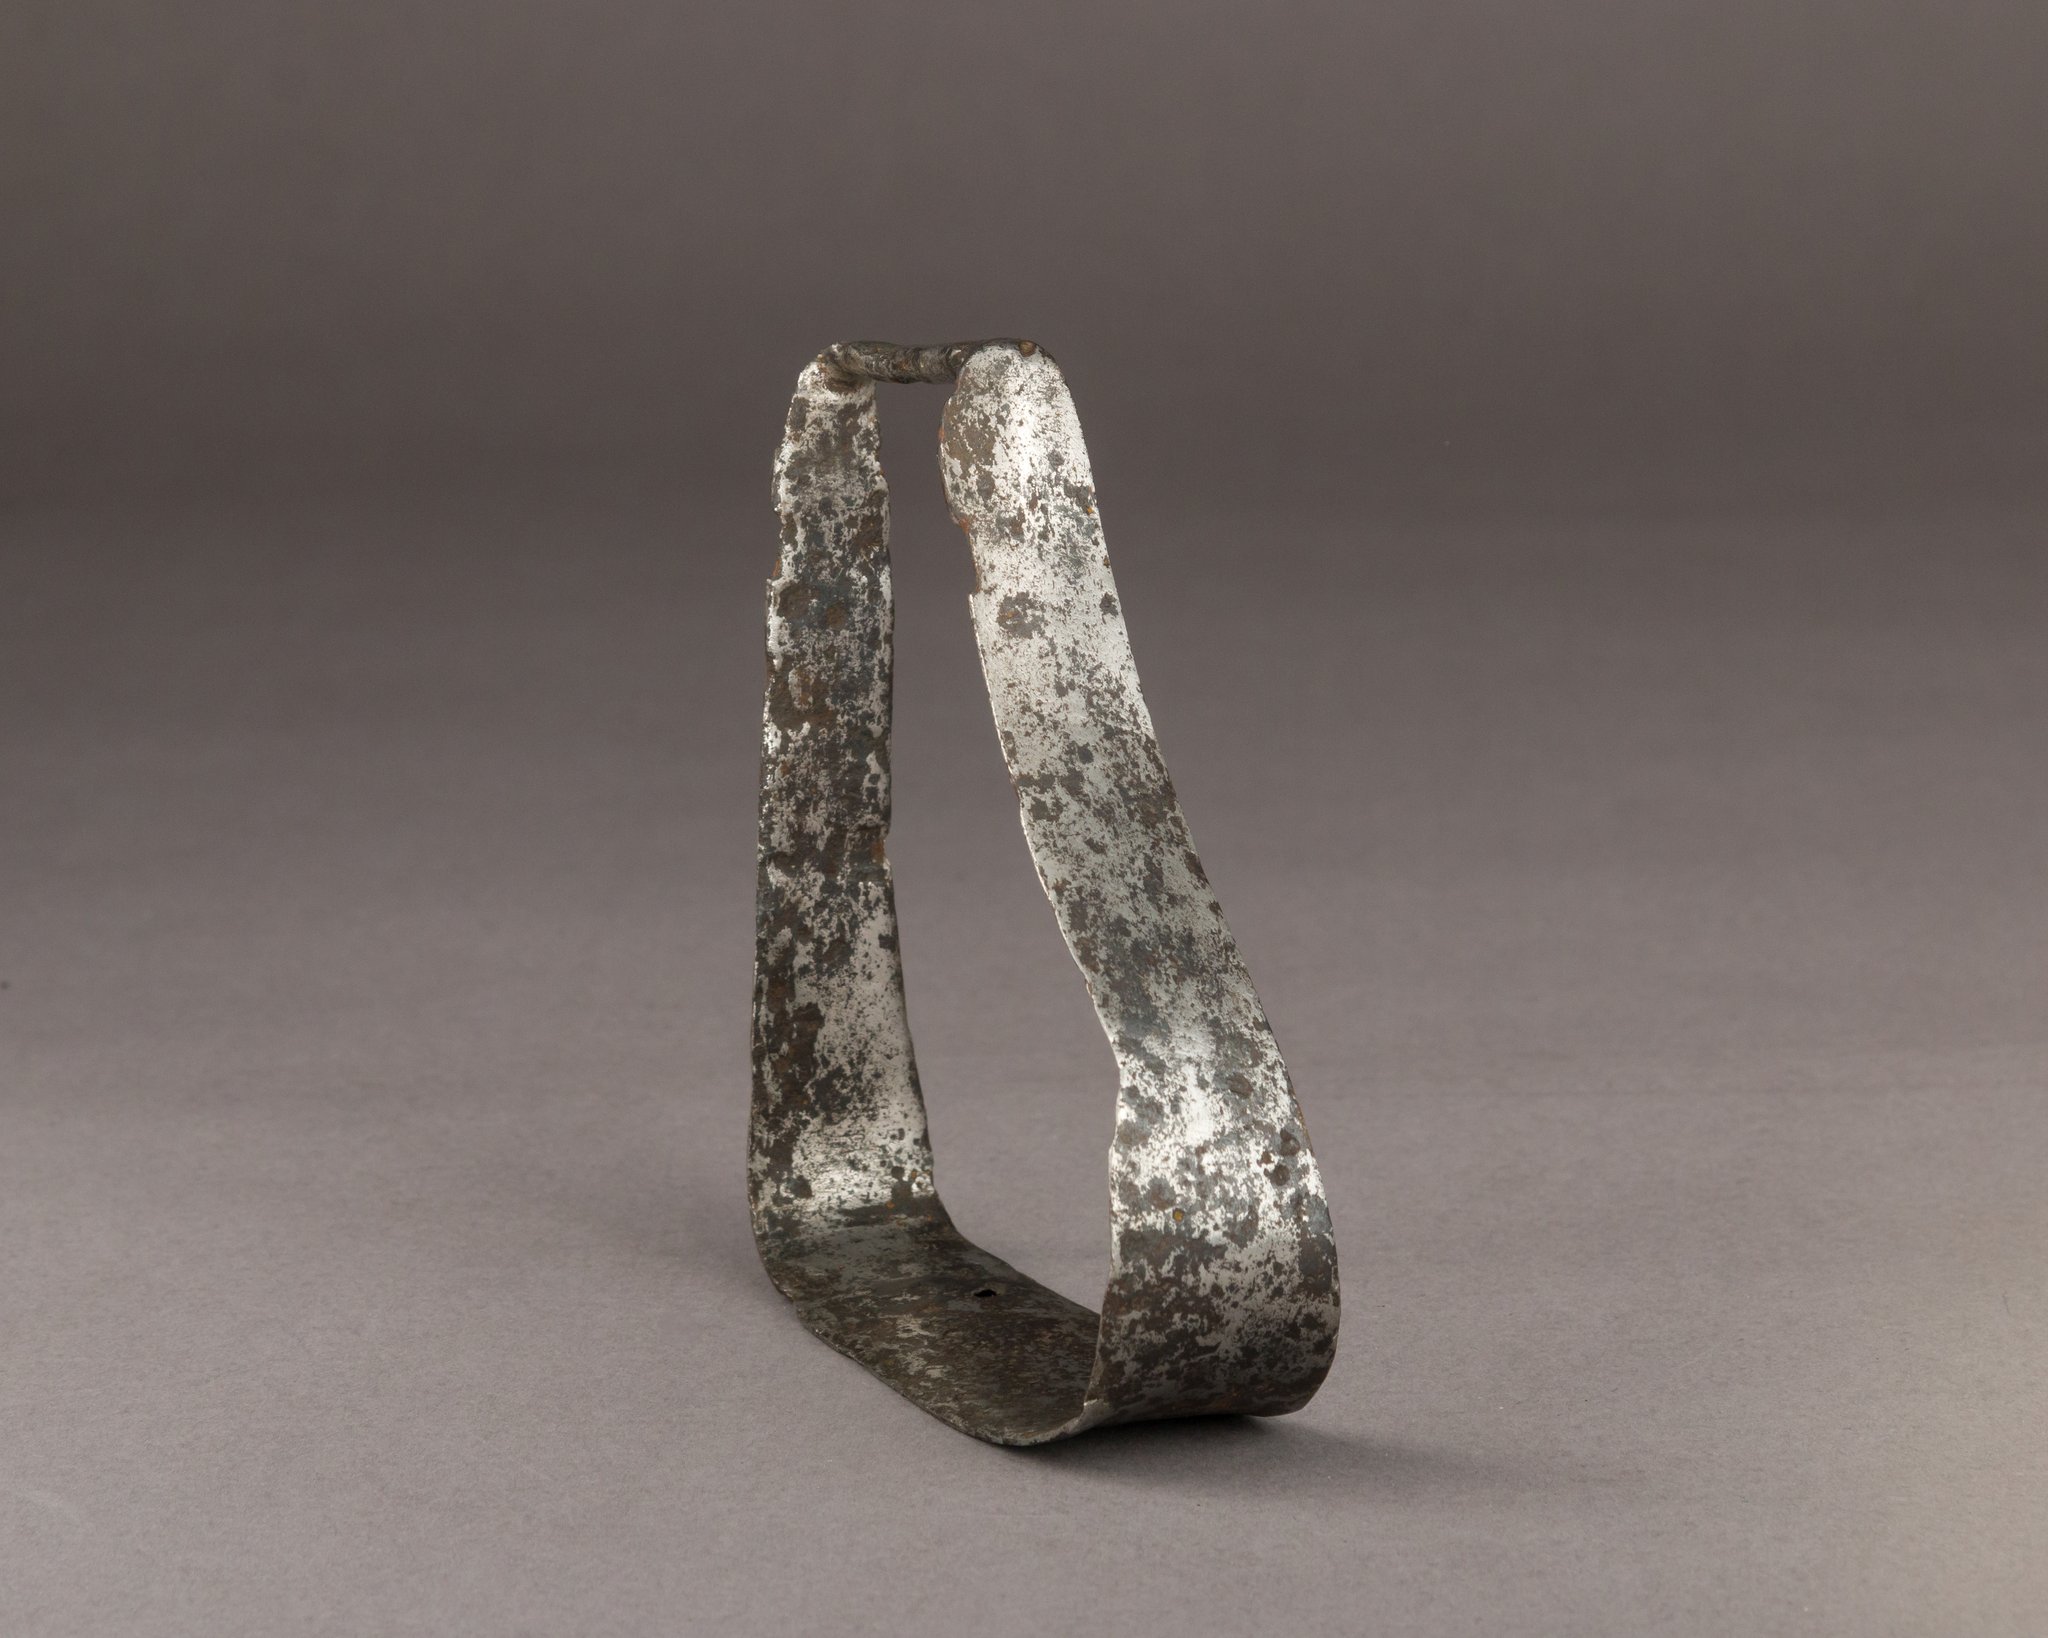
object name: stirrup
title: Left Stirrup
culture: german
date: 1401-1433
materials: iron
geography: germany